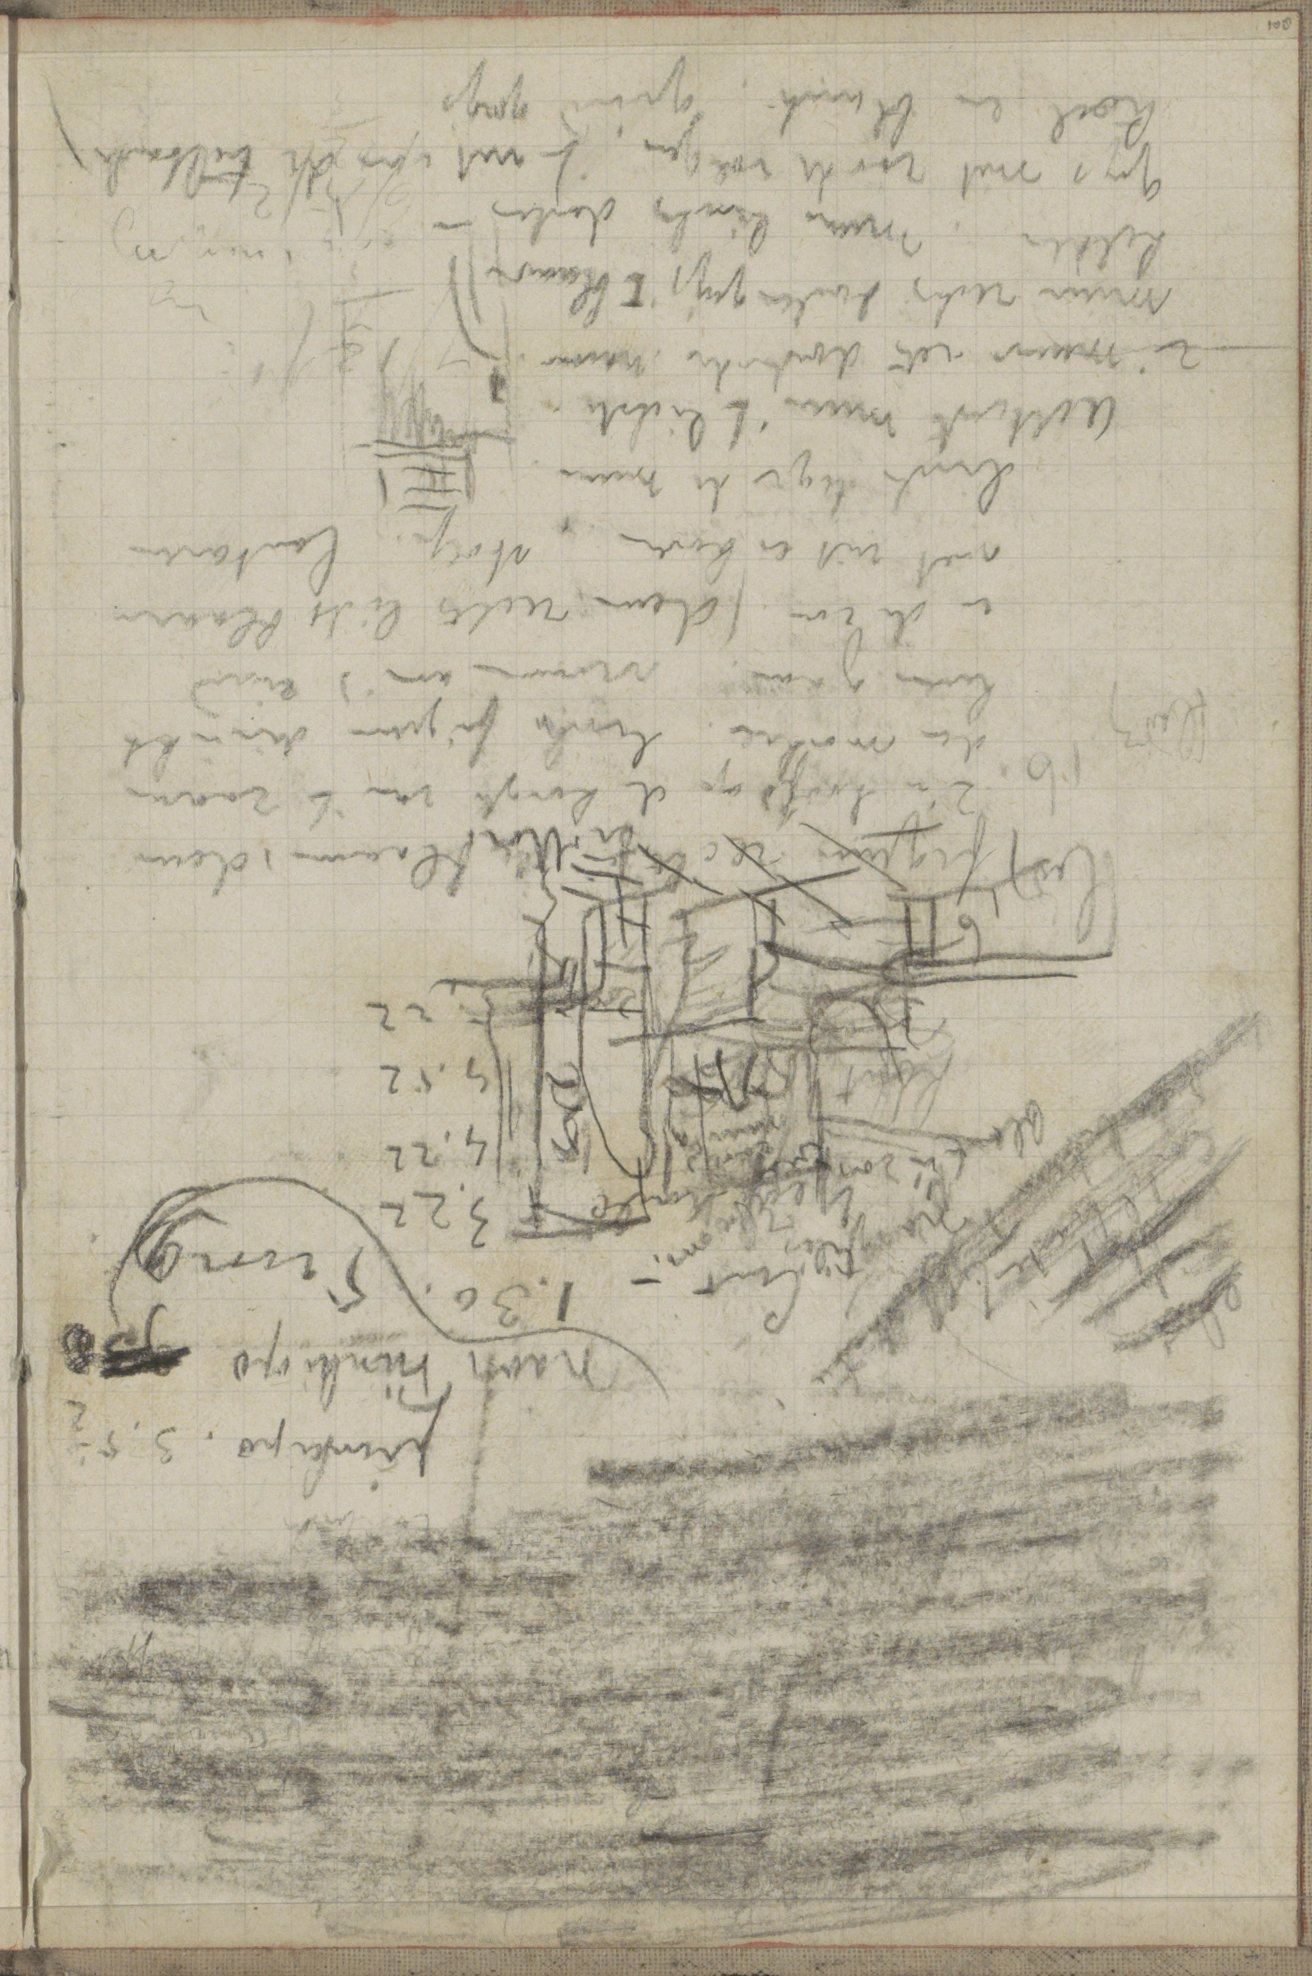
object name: sketchbook leaf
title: Studieblad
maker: marius bauer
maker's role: draughtsman, print maker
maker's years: 1867-1932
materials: chalk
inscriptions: annotation: ‘[...] naar Prinkipo [...]’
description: Pagina 108 uit een schetsboek met 54 bladen.